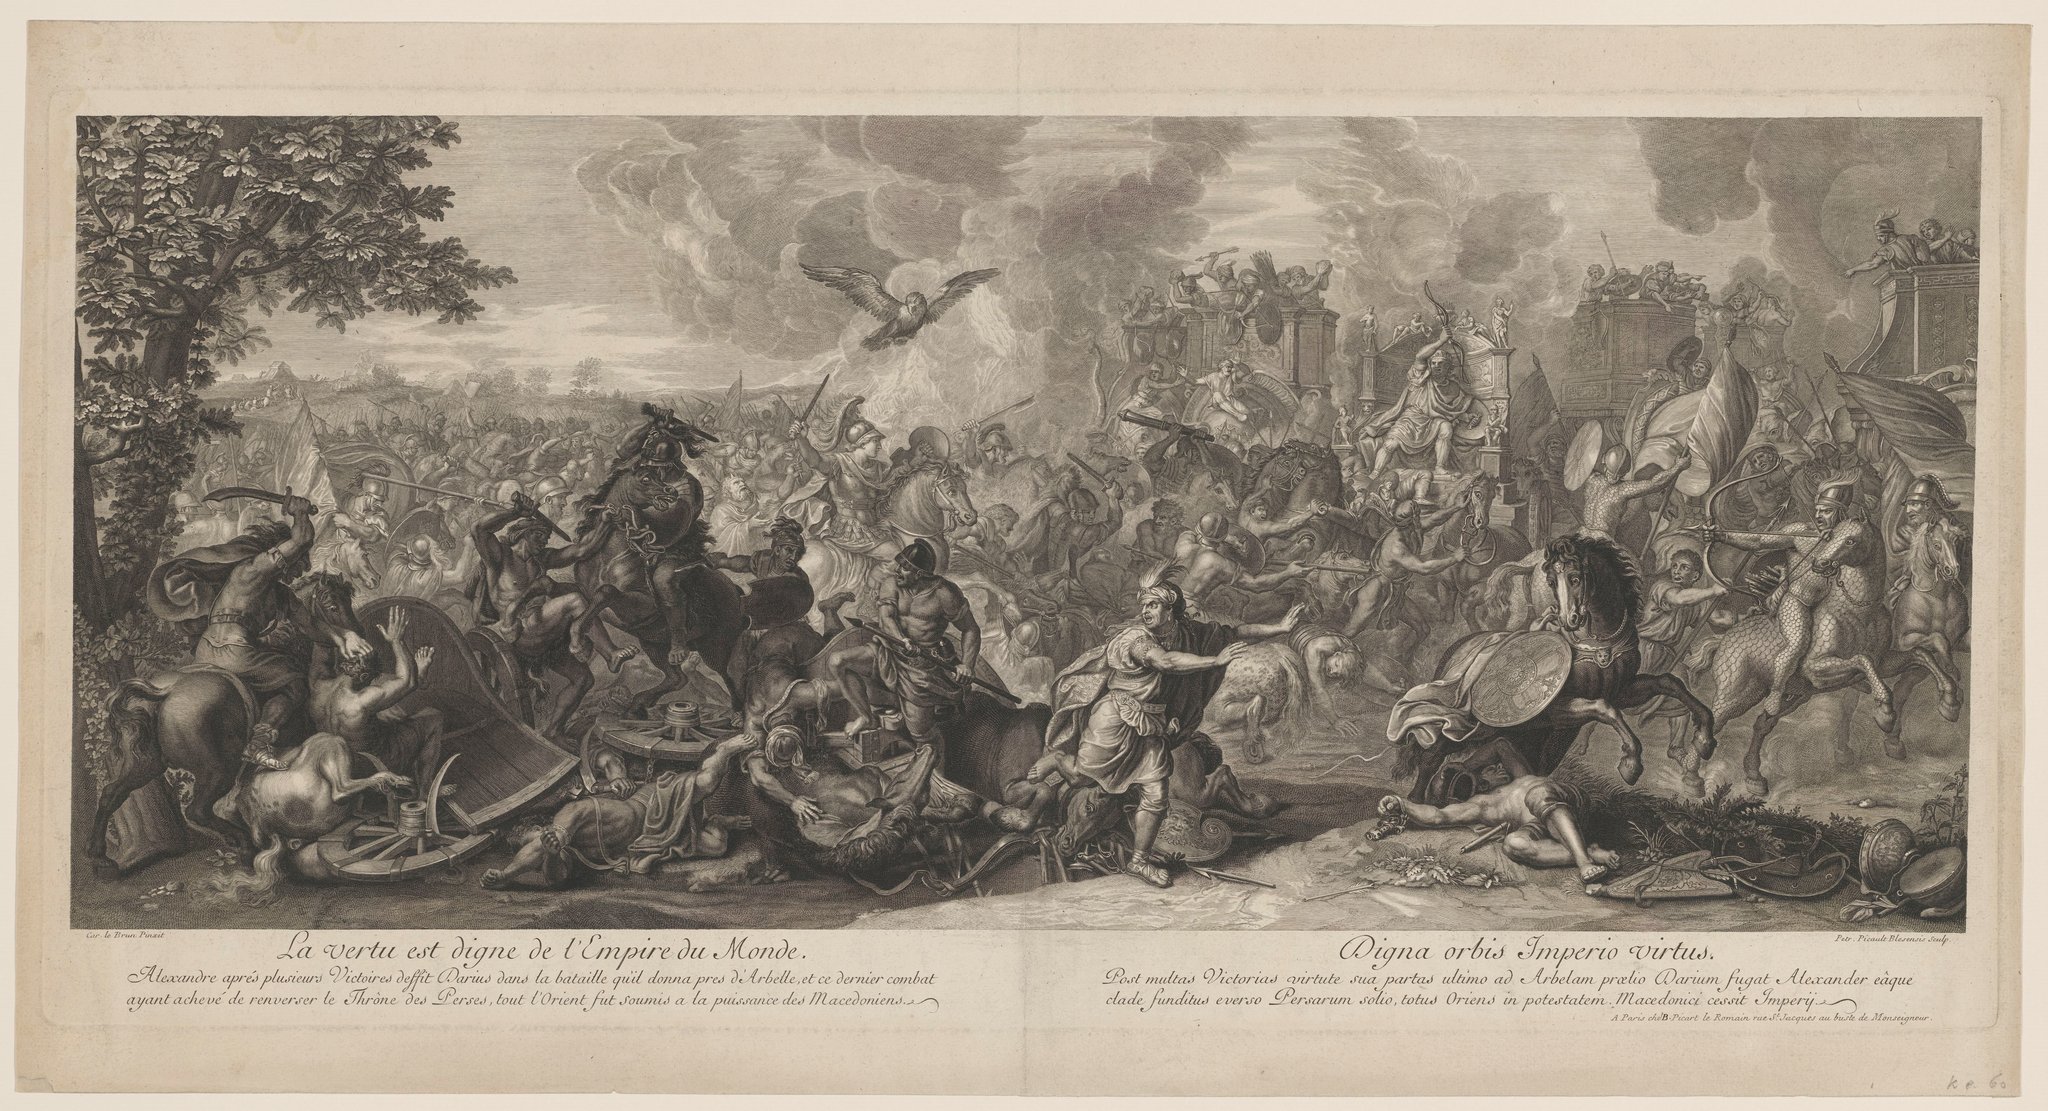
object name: print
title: Le vertu est digne de l'empire du monde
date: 1690-1711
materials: paper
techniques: engraving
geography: paris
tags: alexander fighting against darius at issus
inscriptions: collector's mark: Lugt 240